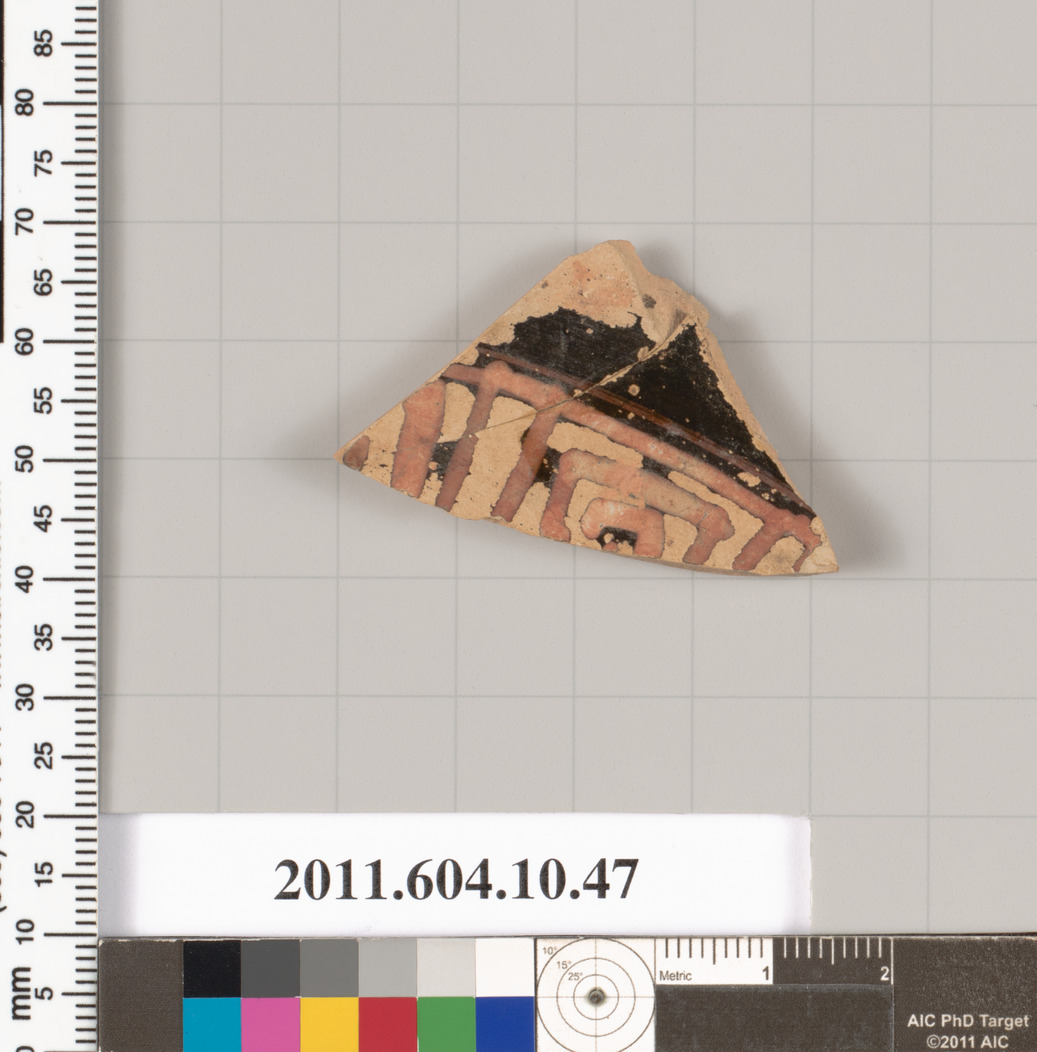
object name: kylix fragment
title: Terracotta fragment of a kylix (drinking cup)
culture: etruscan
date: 334-301 BCE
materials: terracotta